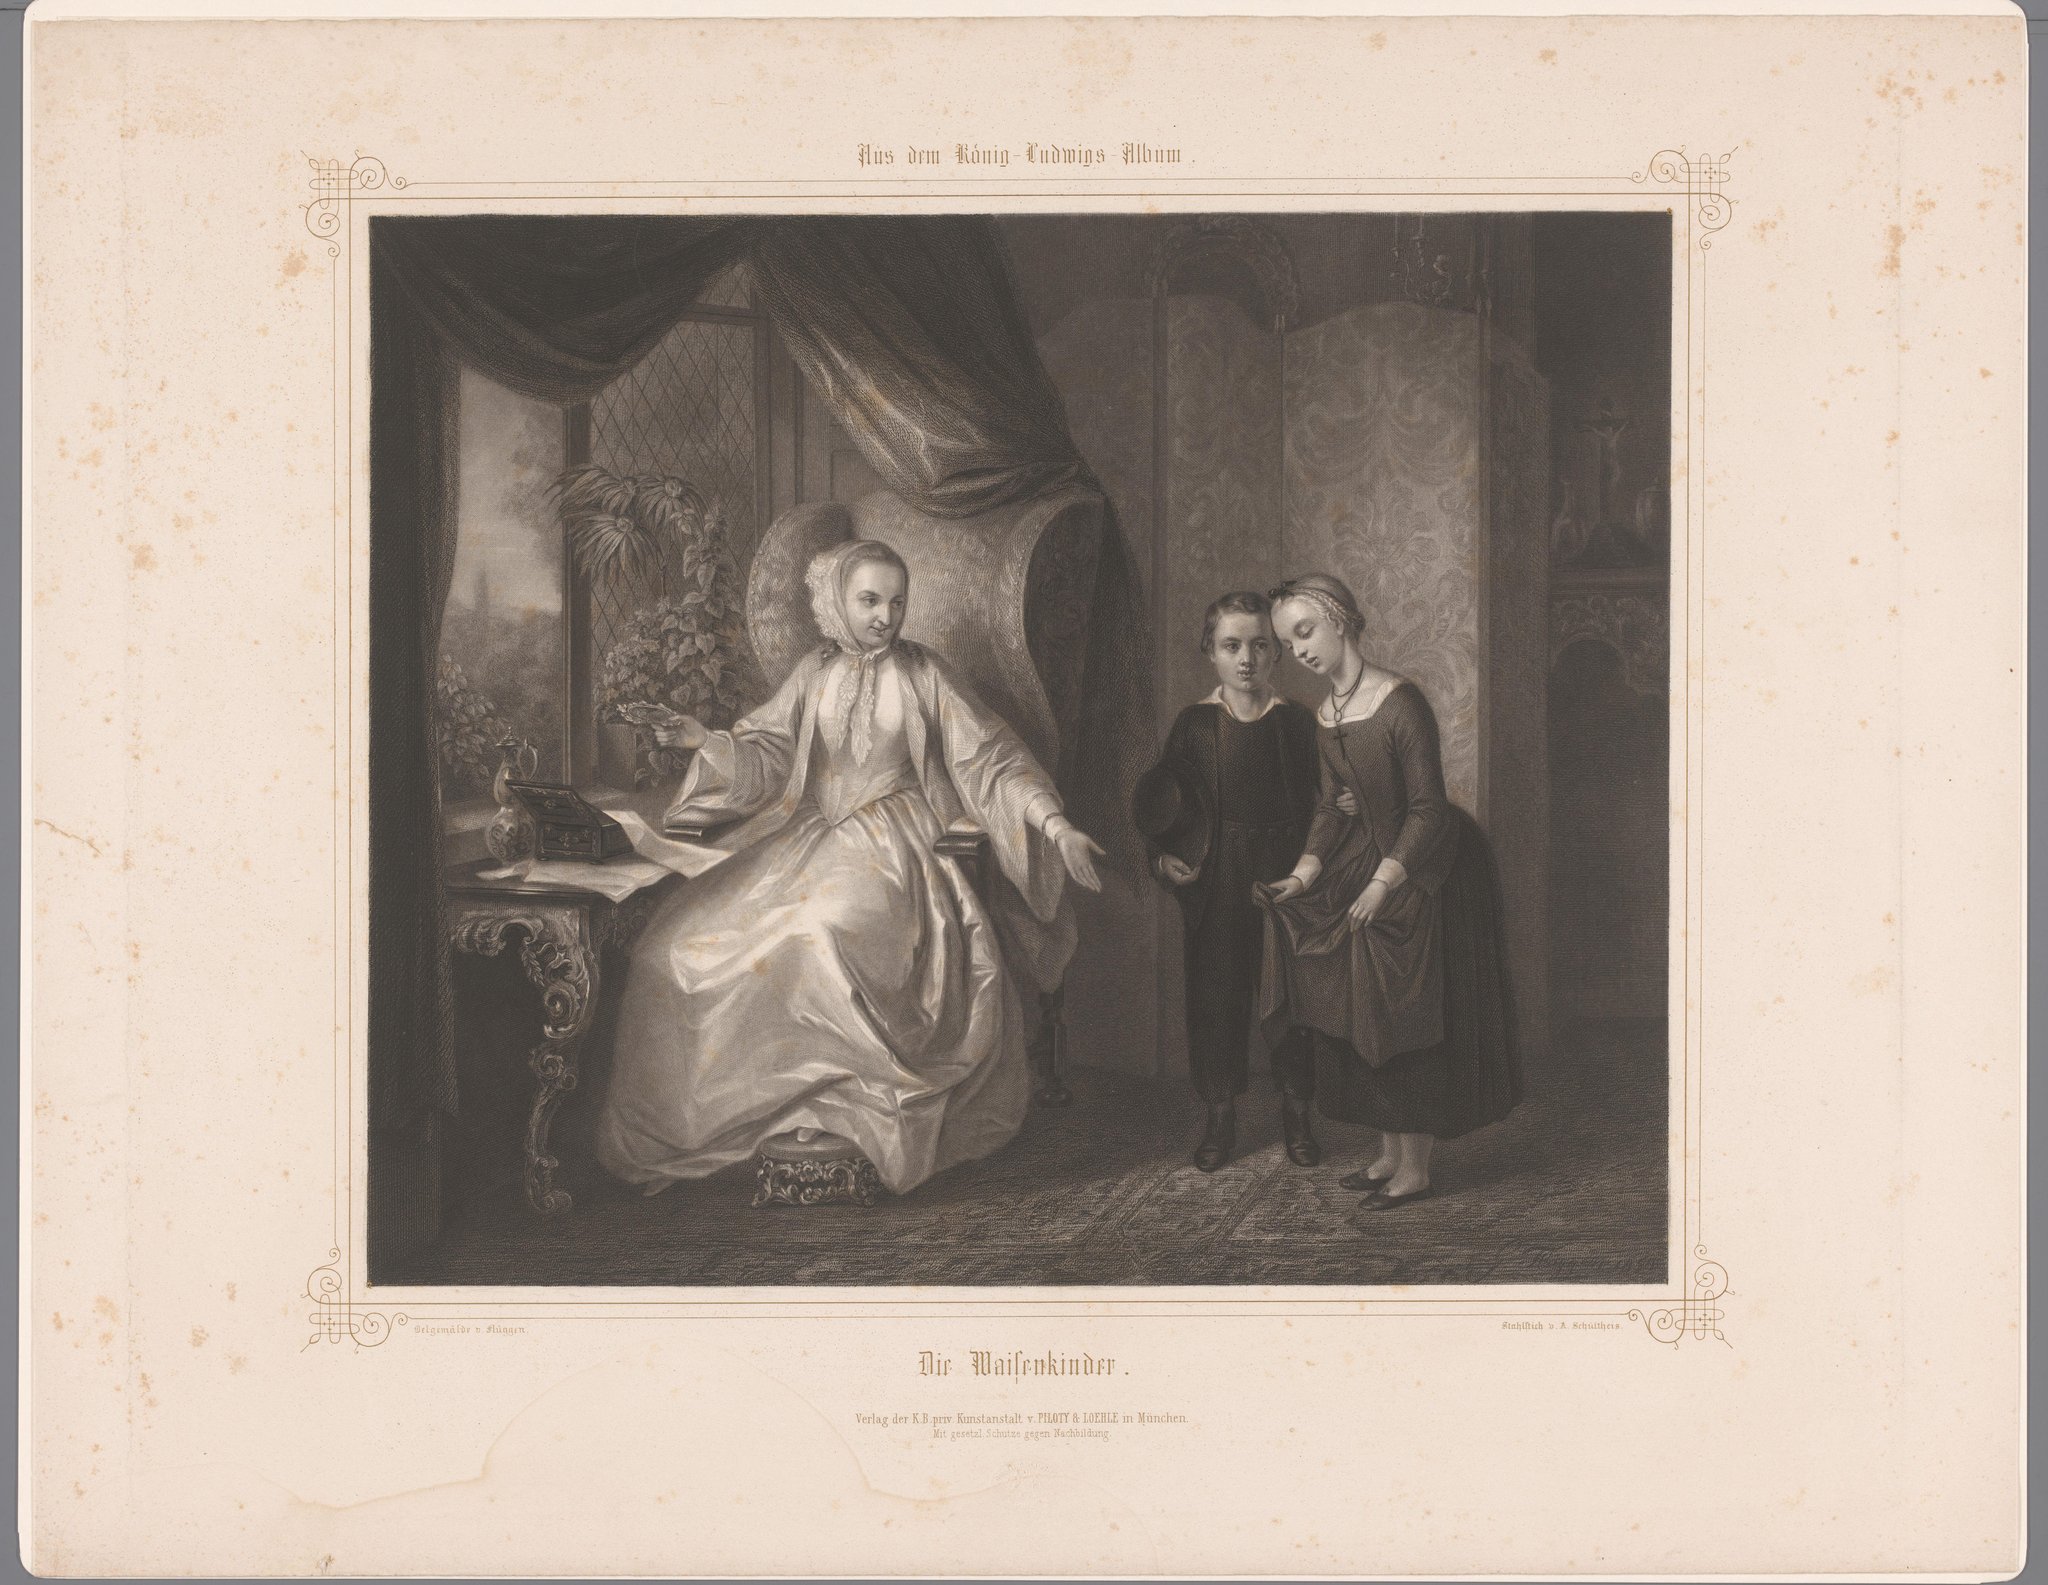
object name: print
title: Die Waisenkinder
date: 1850-1859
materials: paper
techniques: lithograph, engraving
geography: munich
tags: lodewijk i (koning van beieren), orphans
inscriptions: collector's mark: Lugt 2228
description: Prent afkomstig uit de serie 'Album Seiner Majestät des Königs Ludwig I. von Bayern', verschenen in verschillende afleveringen. De prenten gaan terug op het album dat Lodewijk I van Beieren op 9 oktober 1850 kreeg overhandigd van verschillende kunstenaars.